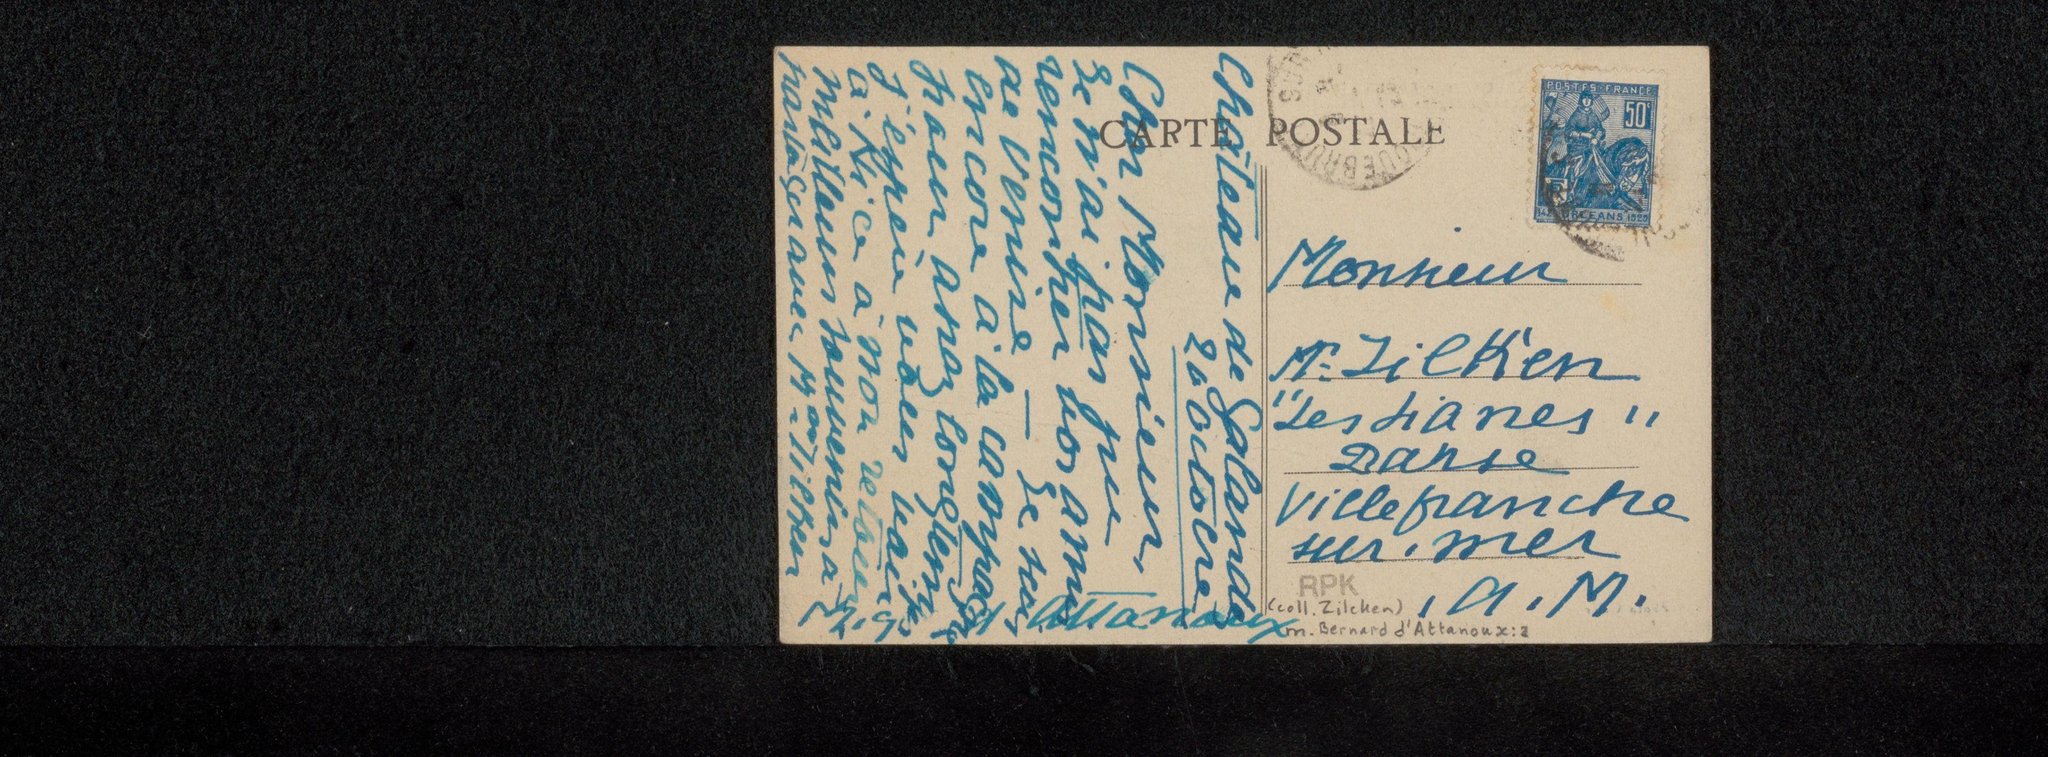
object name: ansichtkaart, prentbriefkaart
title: Prentbriefkaart aan Philip Zilcken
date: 1867-1930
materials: cardboard, ink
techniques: photograph, pen, writing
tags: the hague, painter, draughtsman, philip zilcken, venice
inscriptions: collector's mark: ‘RPK’